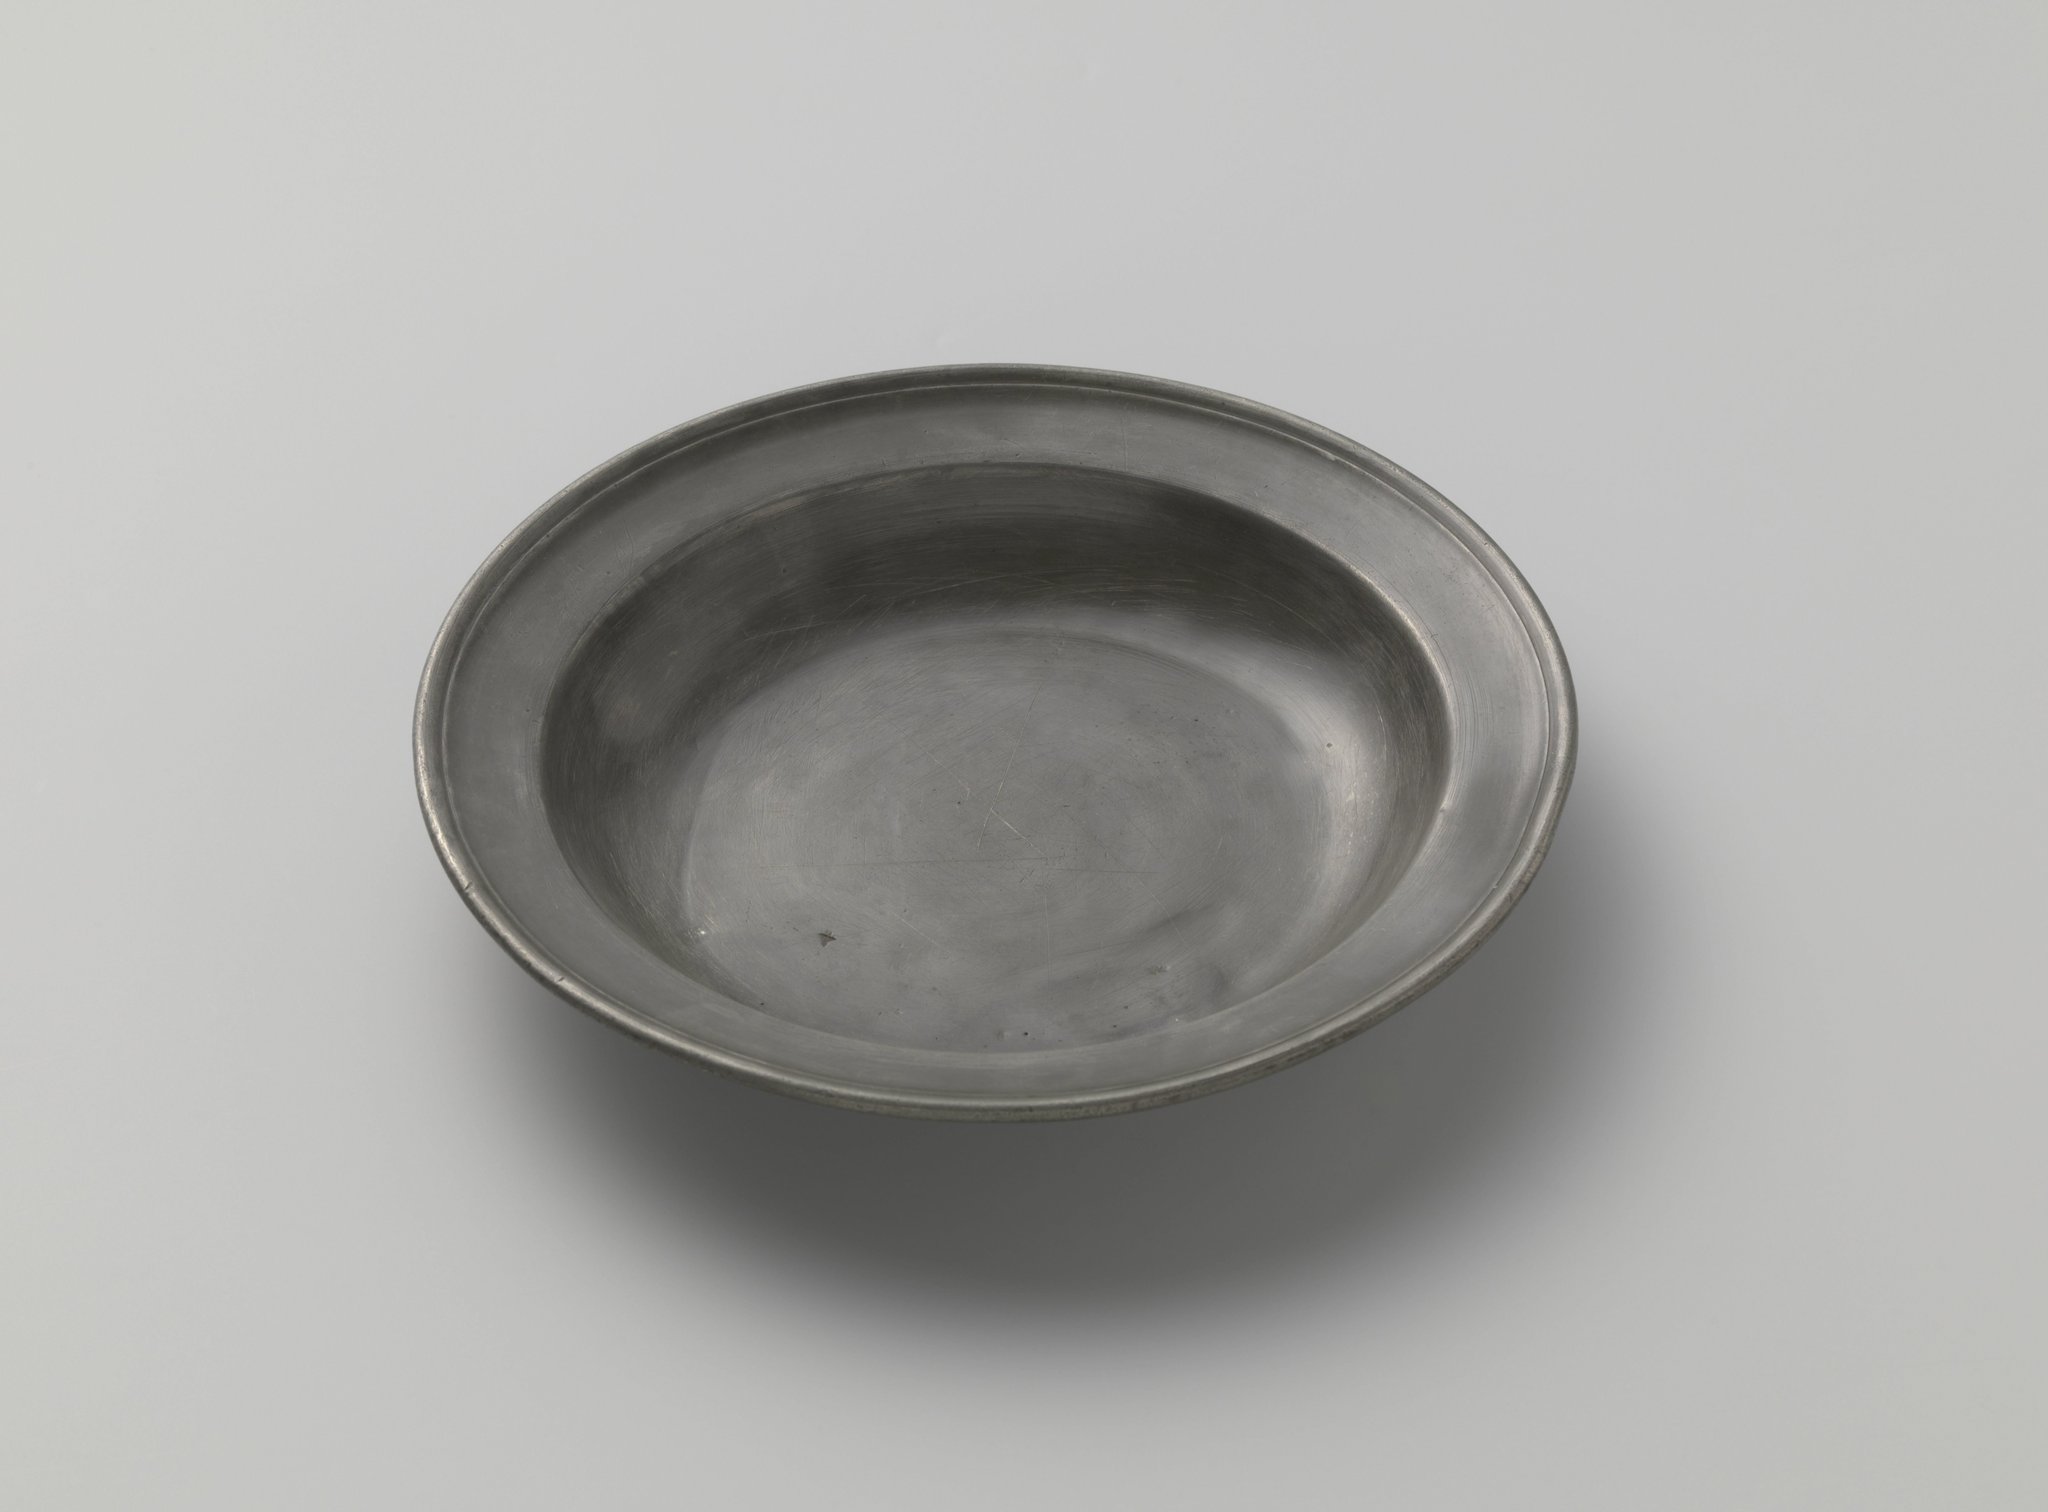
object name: plate dish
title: Rond bord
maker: Anonymous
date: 1700-1800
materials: tin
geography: low countries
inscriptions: quality mark, quality mark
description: Rond bord van tin. De dunne rand is omgeslagen.